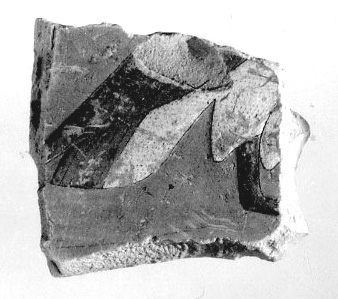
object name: relief fragment, tomb of meketre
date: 1981-1975 BCE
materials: limestone, paint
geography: egypt